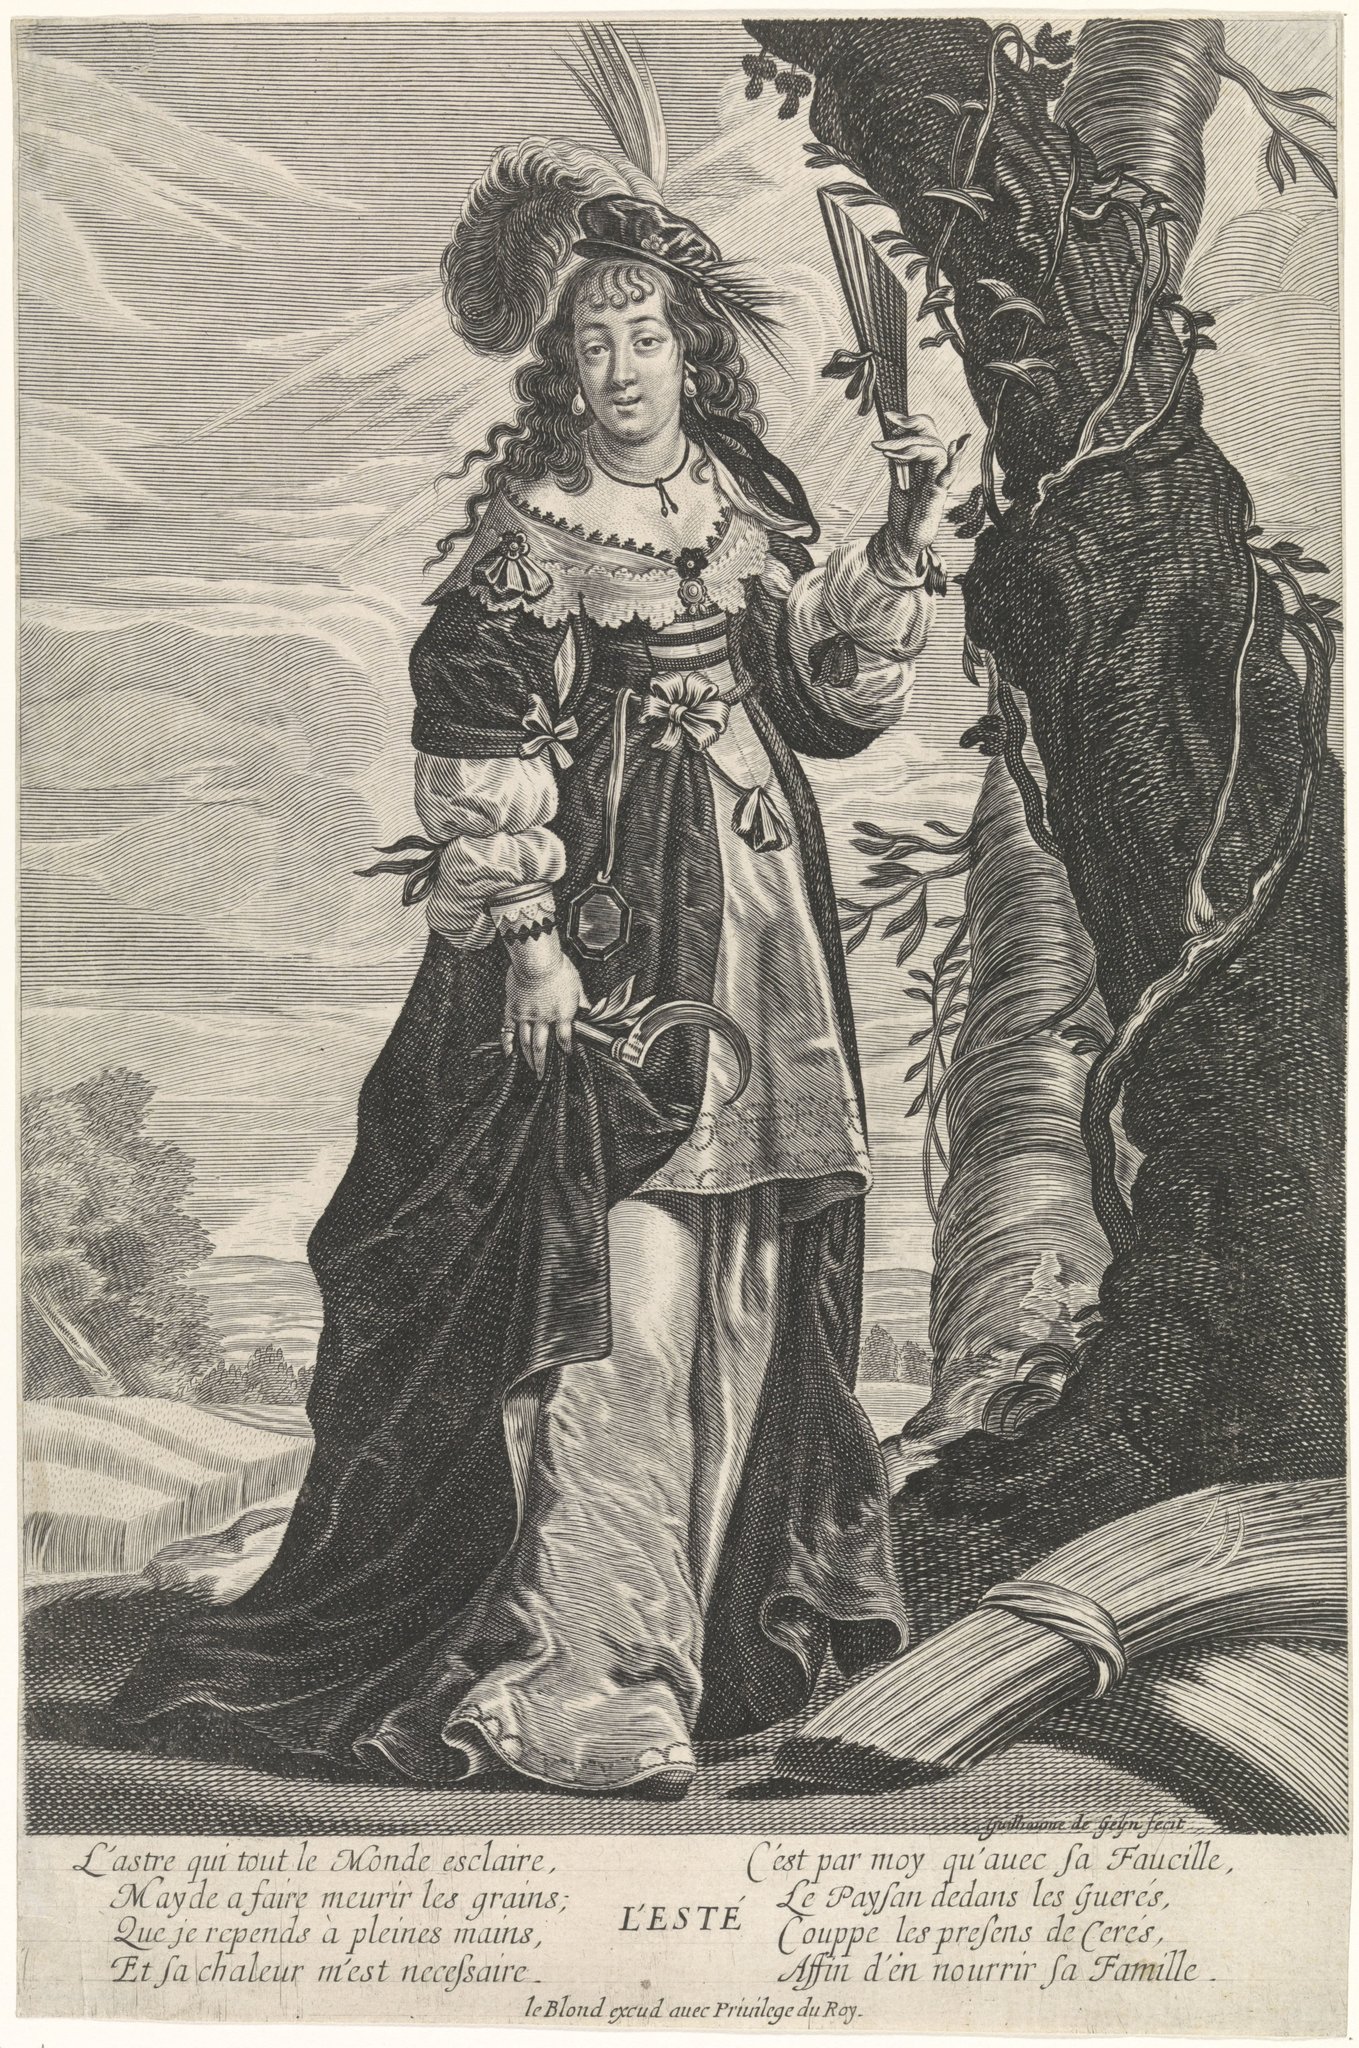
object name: print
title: De vier seizoenen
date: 1620-1650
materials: paper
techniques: engraving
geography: paris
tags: summer, 'aestas'; 'estate' (ripa) (+ human occupations representing seasons and months)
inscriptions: collector's mark: Lugt 2228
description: De zomer in de gedaante van een vrouw in zeventiende-eeuwse kleding. In de ene hand een waaier, in de andere een sikkel. Naast haar een korenveld en een bundel koren. De prent heeft een Frans onderschrift en is deel van een serie met de vier seizoenen als onderwerp.